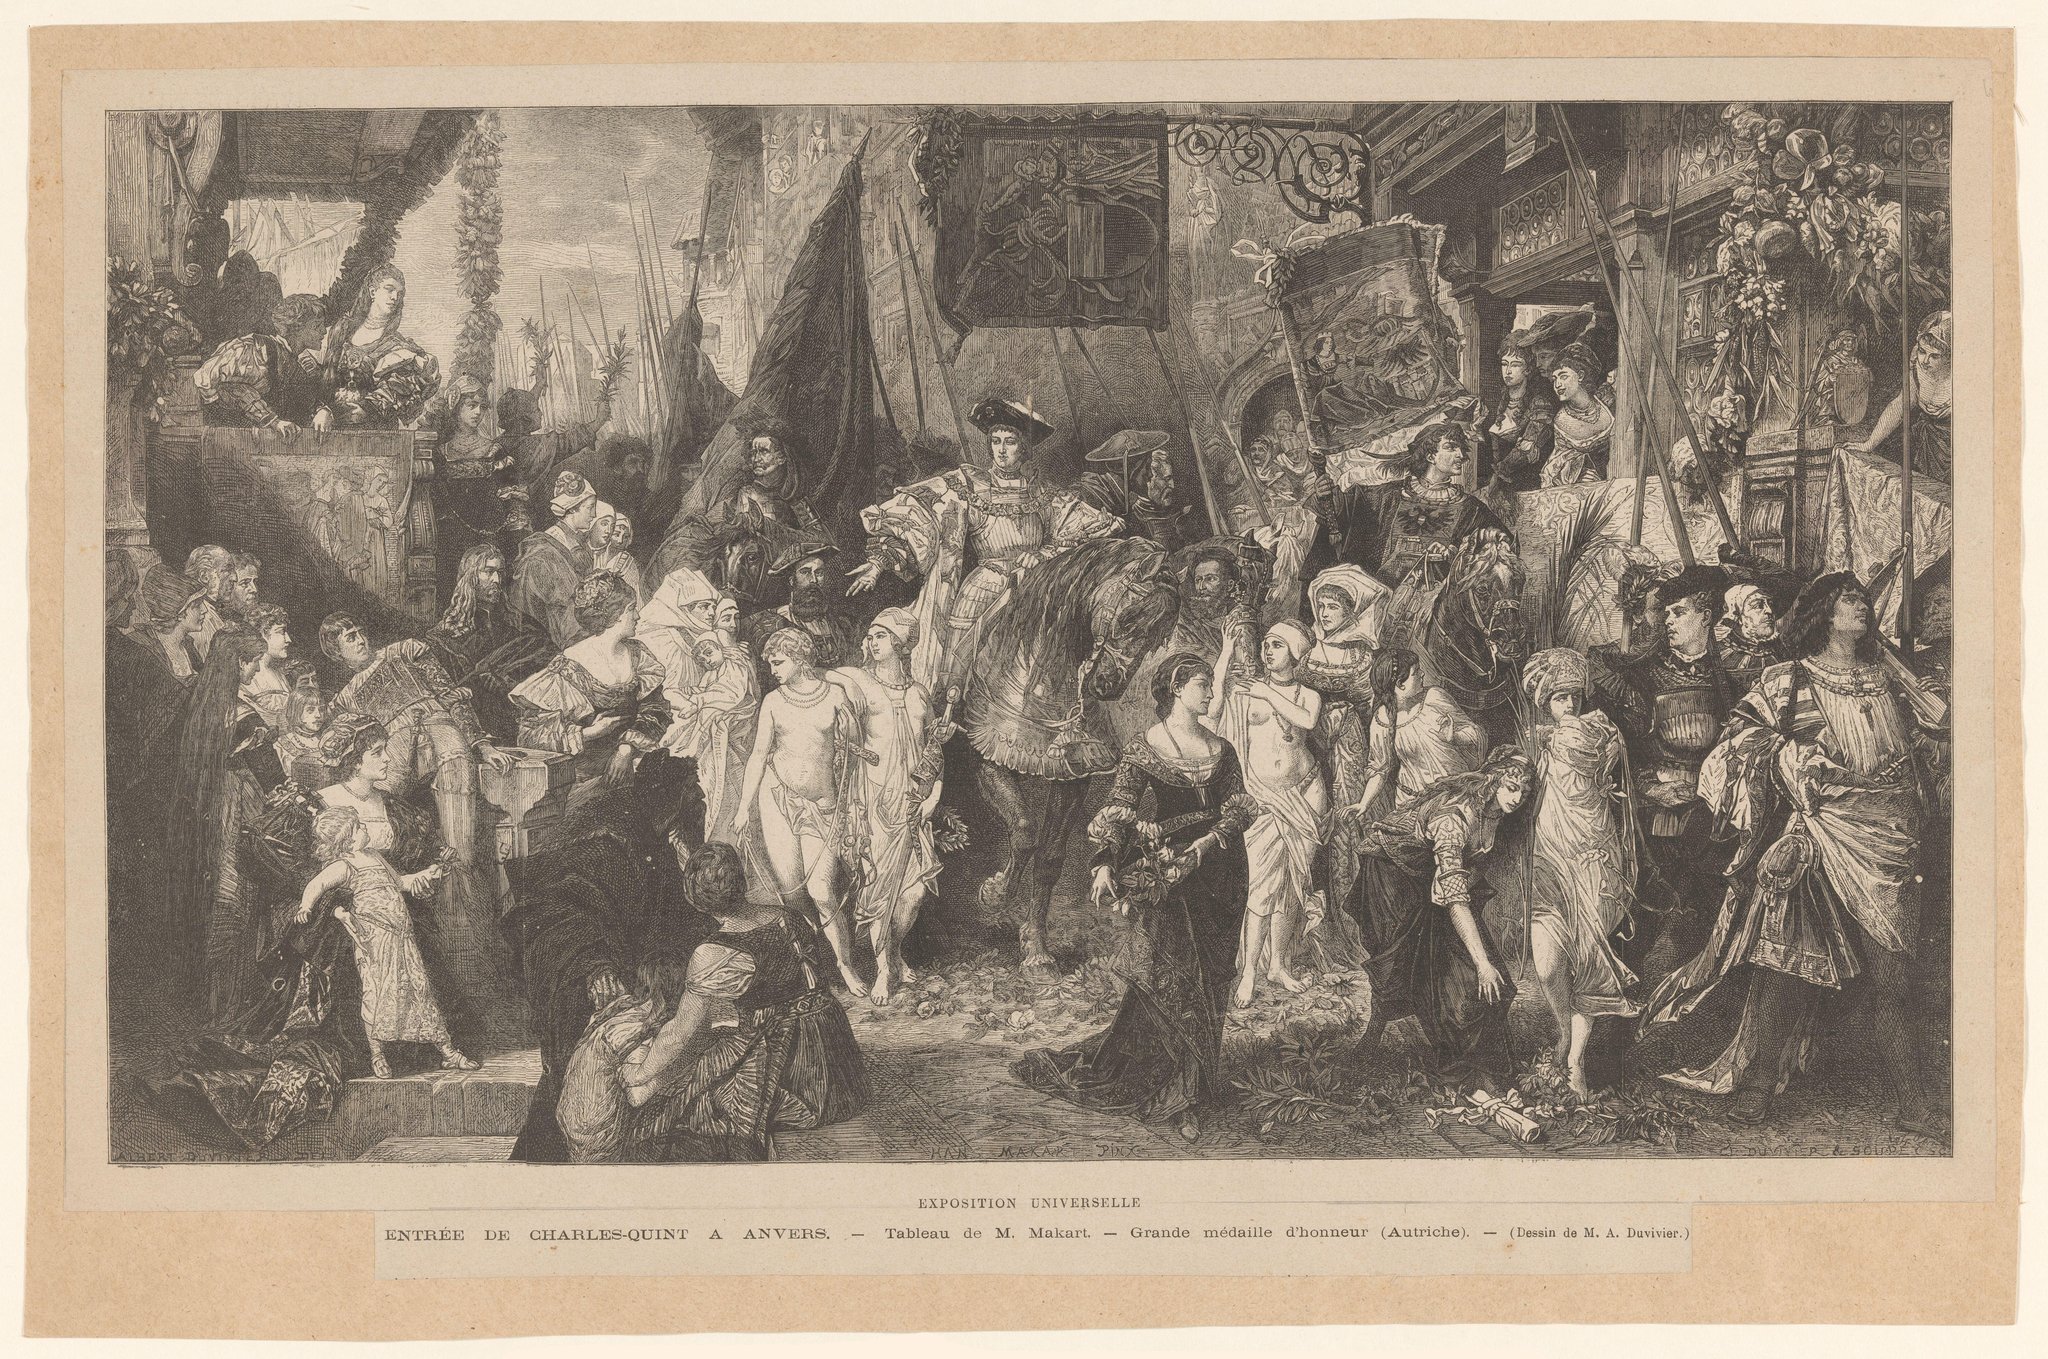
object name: print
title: Intocht van keizer Karel V in Antwerpen, 1525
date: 1878-1882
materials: paper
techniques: engraving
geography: netherlands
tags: ghent, charles v (holy roman emperor and king of spain), triumphal entry and public reception, pageant, 'entrée solennelle', 'joyeuse entrée', antwerp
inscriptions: collector's mark: Lugt 2228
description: Intocht van keizer Karel V in Antwerpen, 1525. De jonge keizer te paard door de straten van Antwerpen. Reporductie naar een prijswinnende schilderij van Hans Makart.